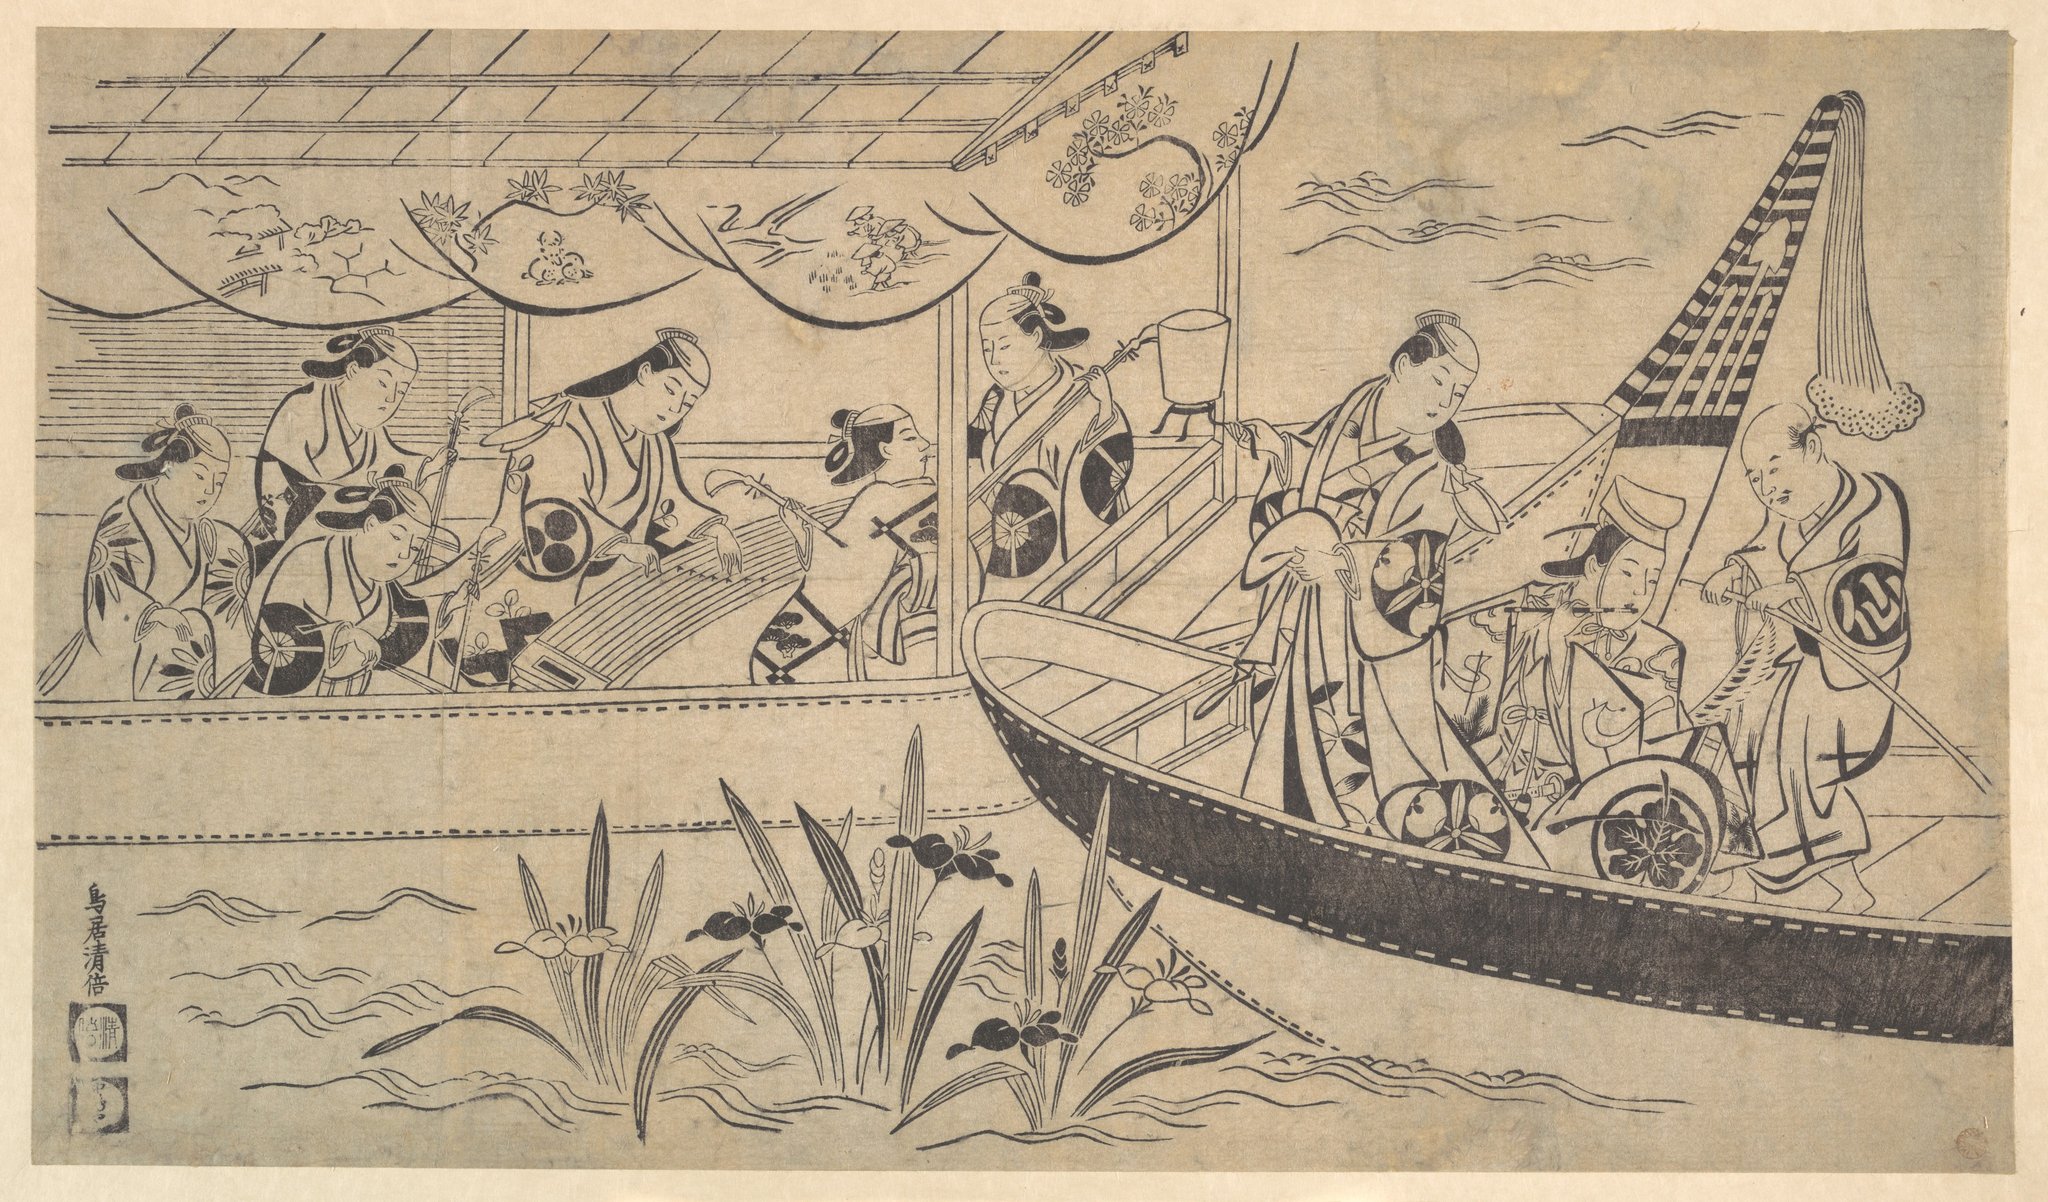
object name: print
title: An Actor's Boating Party on the Sumida River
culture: japanese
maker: torii kiyomasu i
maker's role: artist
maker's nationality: japanese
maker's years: 1696-1716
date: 1705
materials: ink, paper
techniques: woodblock print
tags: musical instruments,rivers,plants,actors,boats